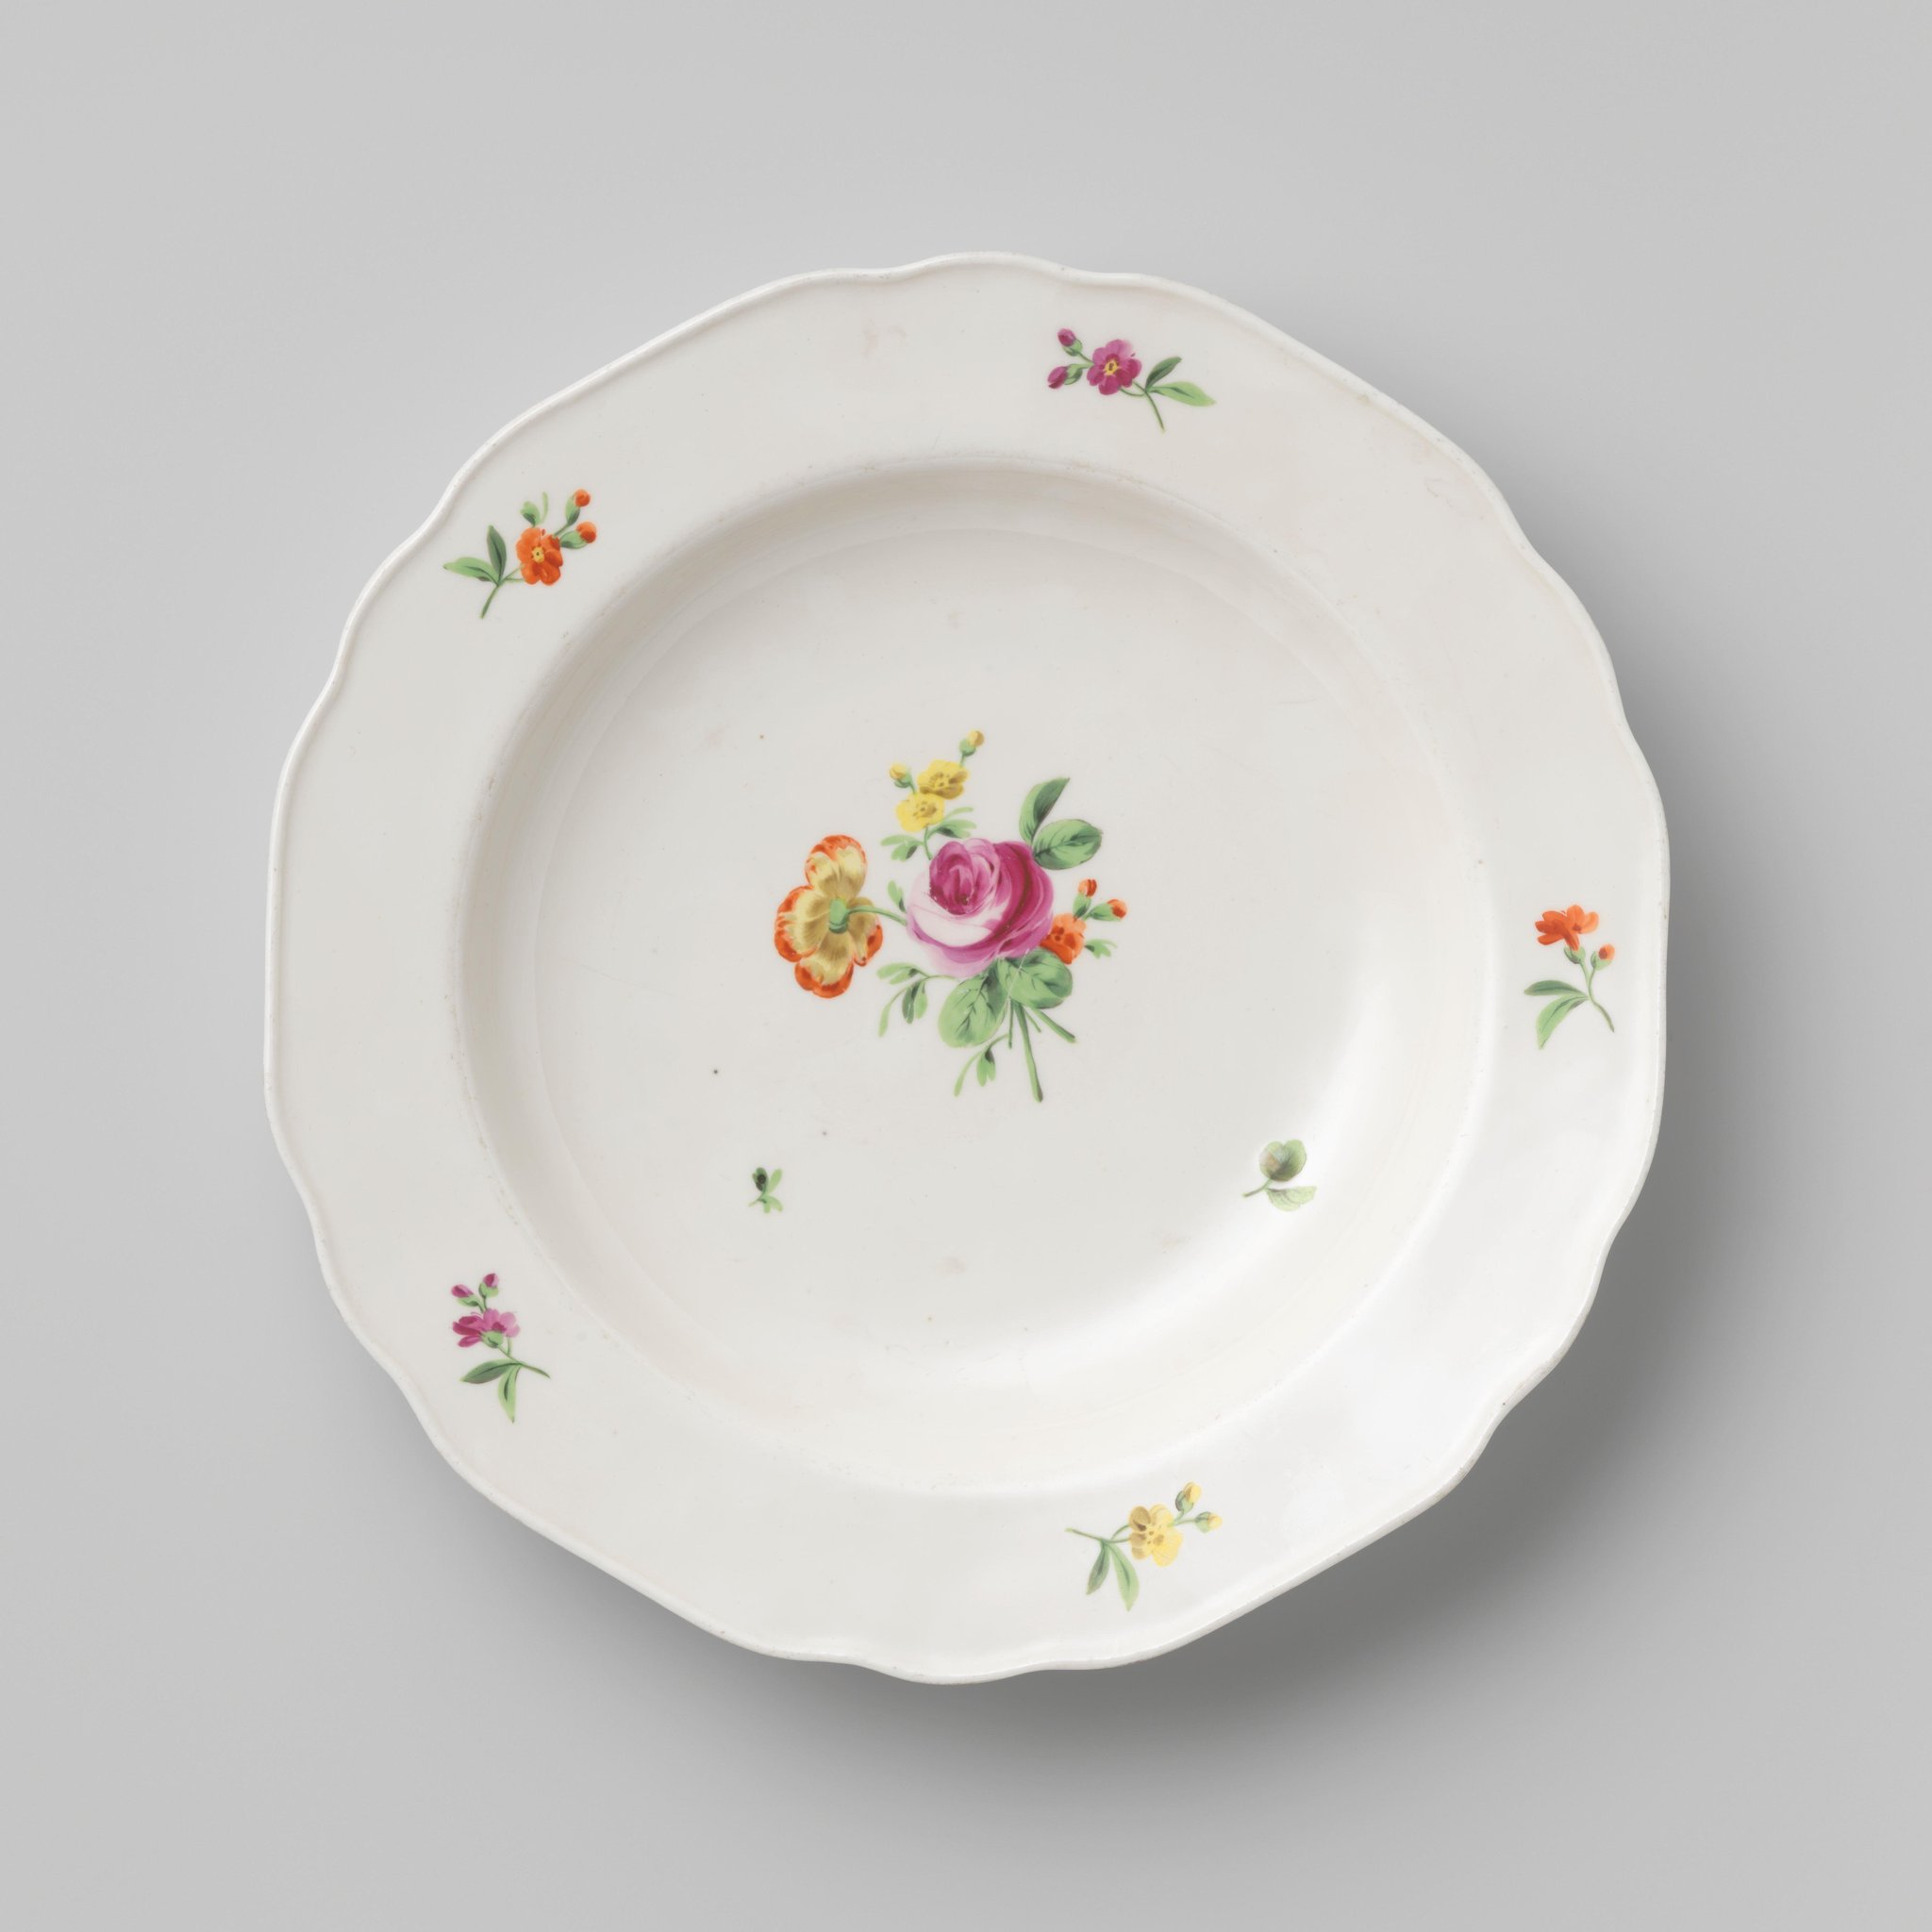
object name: plate dish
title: Plate with a bouquet and flower sprays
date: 1800-1849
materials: glaze, paint, porcelain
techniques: firing, forming, turning, vitrification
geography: vienna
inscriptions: mark: ‘schild/ P/ 17/ 11/ 89/ 4’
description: Bord van porselein met een gelobde rand, beschilderd op het glazuur in rood, groen, geel en paars. Op het plat een boeket van verschillende bloemen (o.a. pioenroos) omgeven door losse takjes en op de rand vijf bloemtakken. Gemerkt op de onderzijde met het schild, de letter P en de nummers 17, 11, 89 en 4.